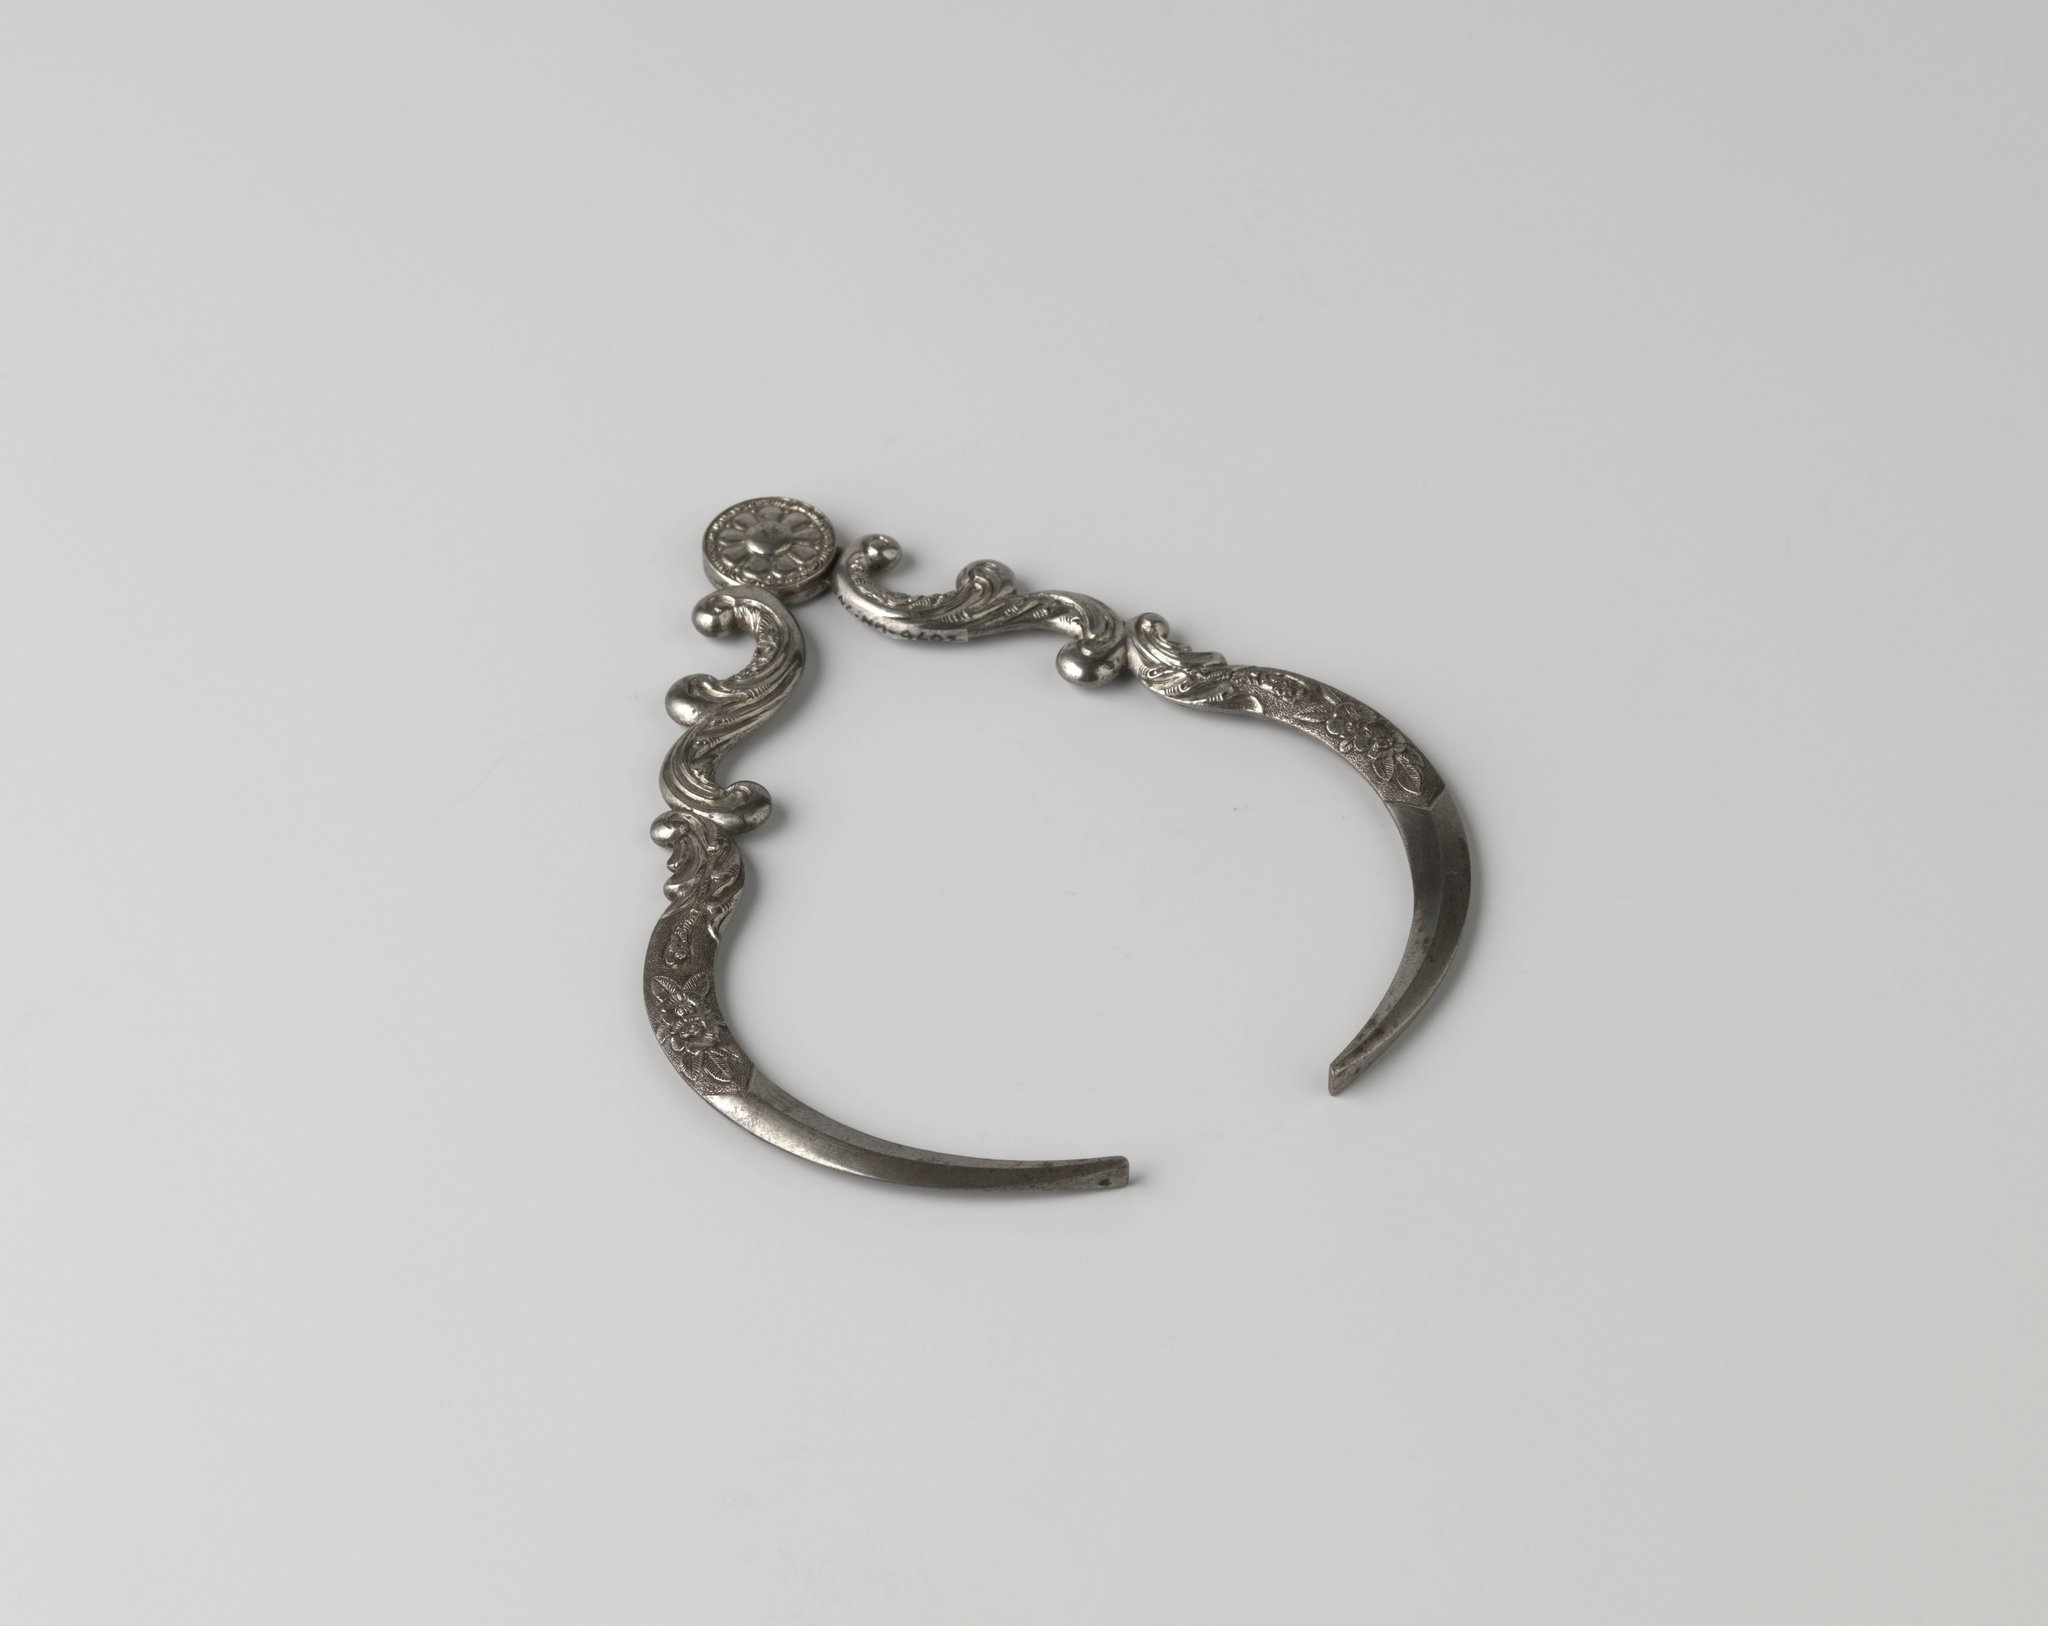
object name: caliper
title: Een krompasser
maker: Anonymous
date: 1725-1775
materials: iron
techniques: metalworking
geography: netherlands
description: Een ijzeren krompasser, rijk geciseleerd, met brede punten.